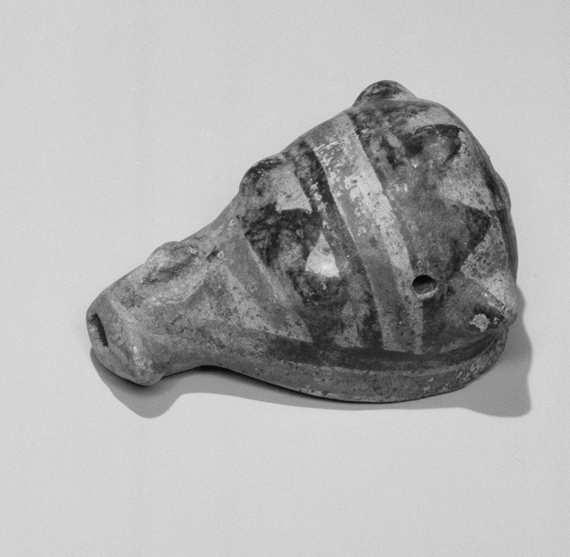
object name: pottery whistle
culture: costa rican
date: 800-1525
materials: paint, pottery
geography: costa rica